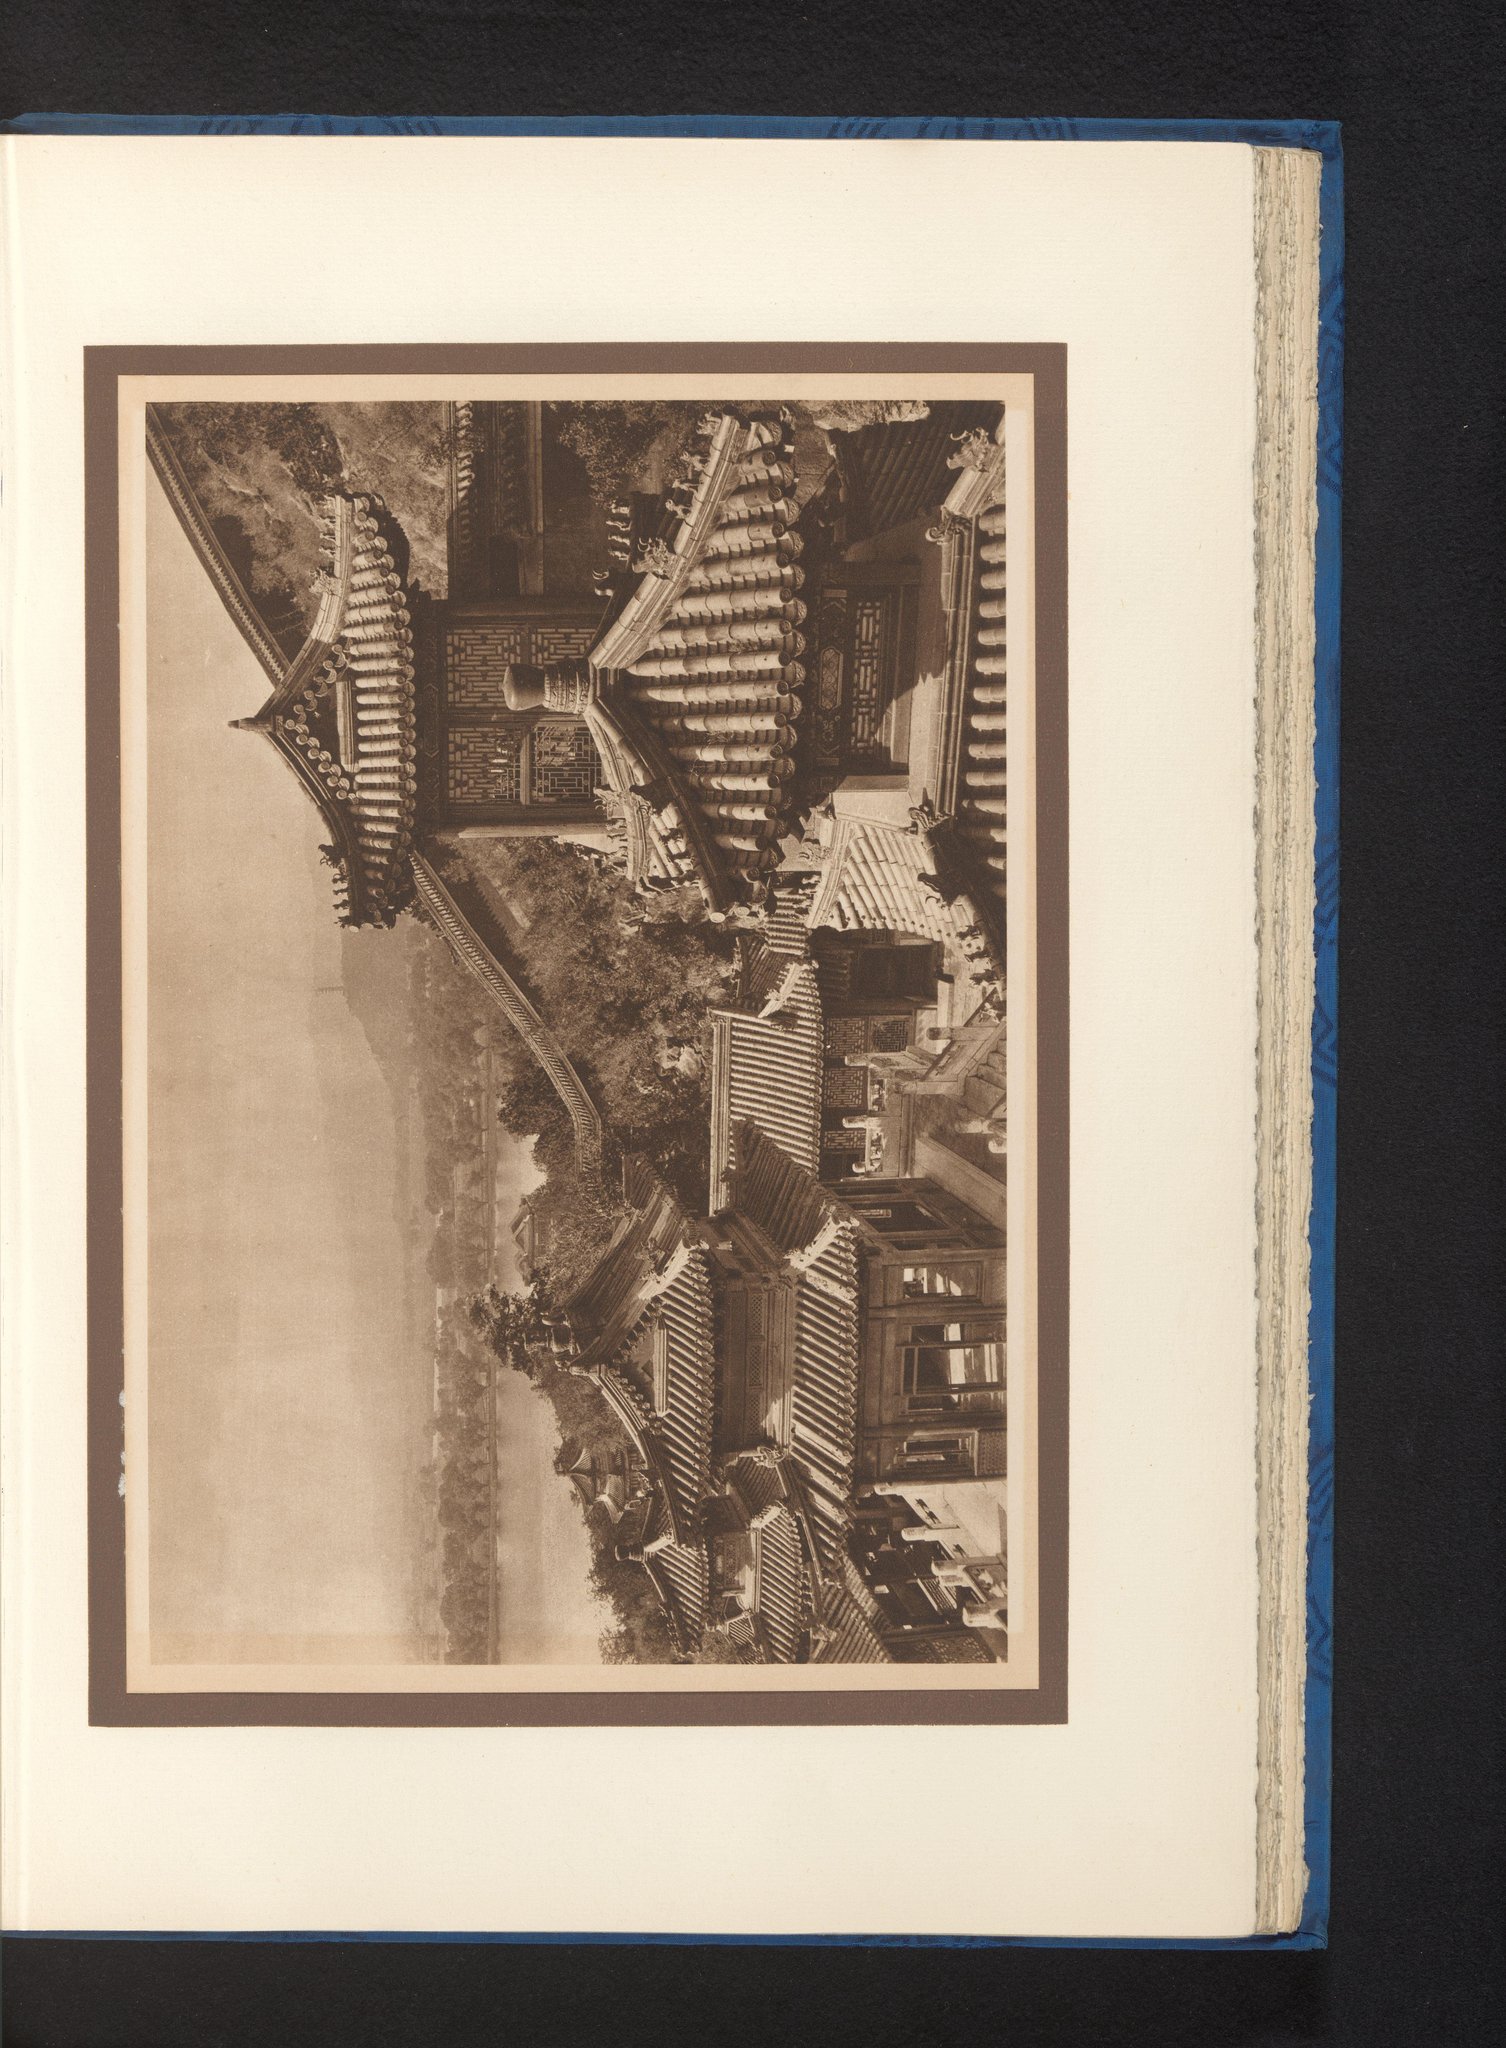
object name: page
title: Zomerpaleis te Peking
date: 1915-1920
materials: paper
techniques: rotogravure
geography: beijing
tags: landscapes with waters, waterscapes, seascapes (in the temperate zone), palace